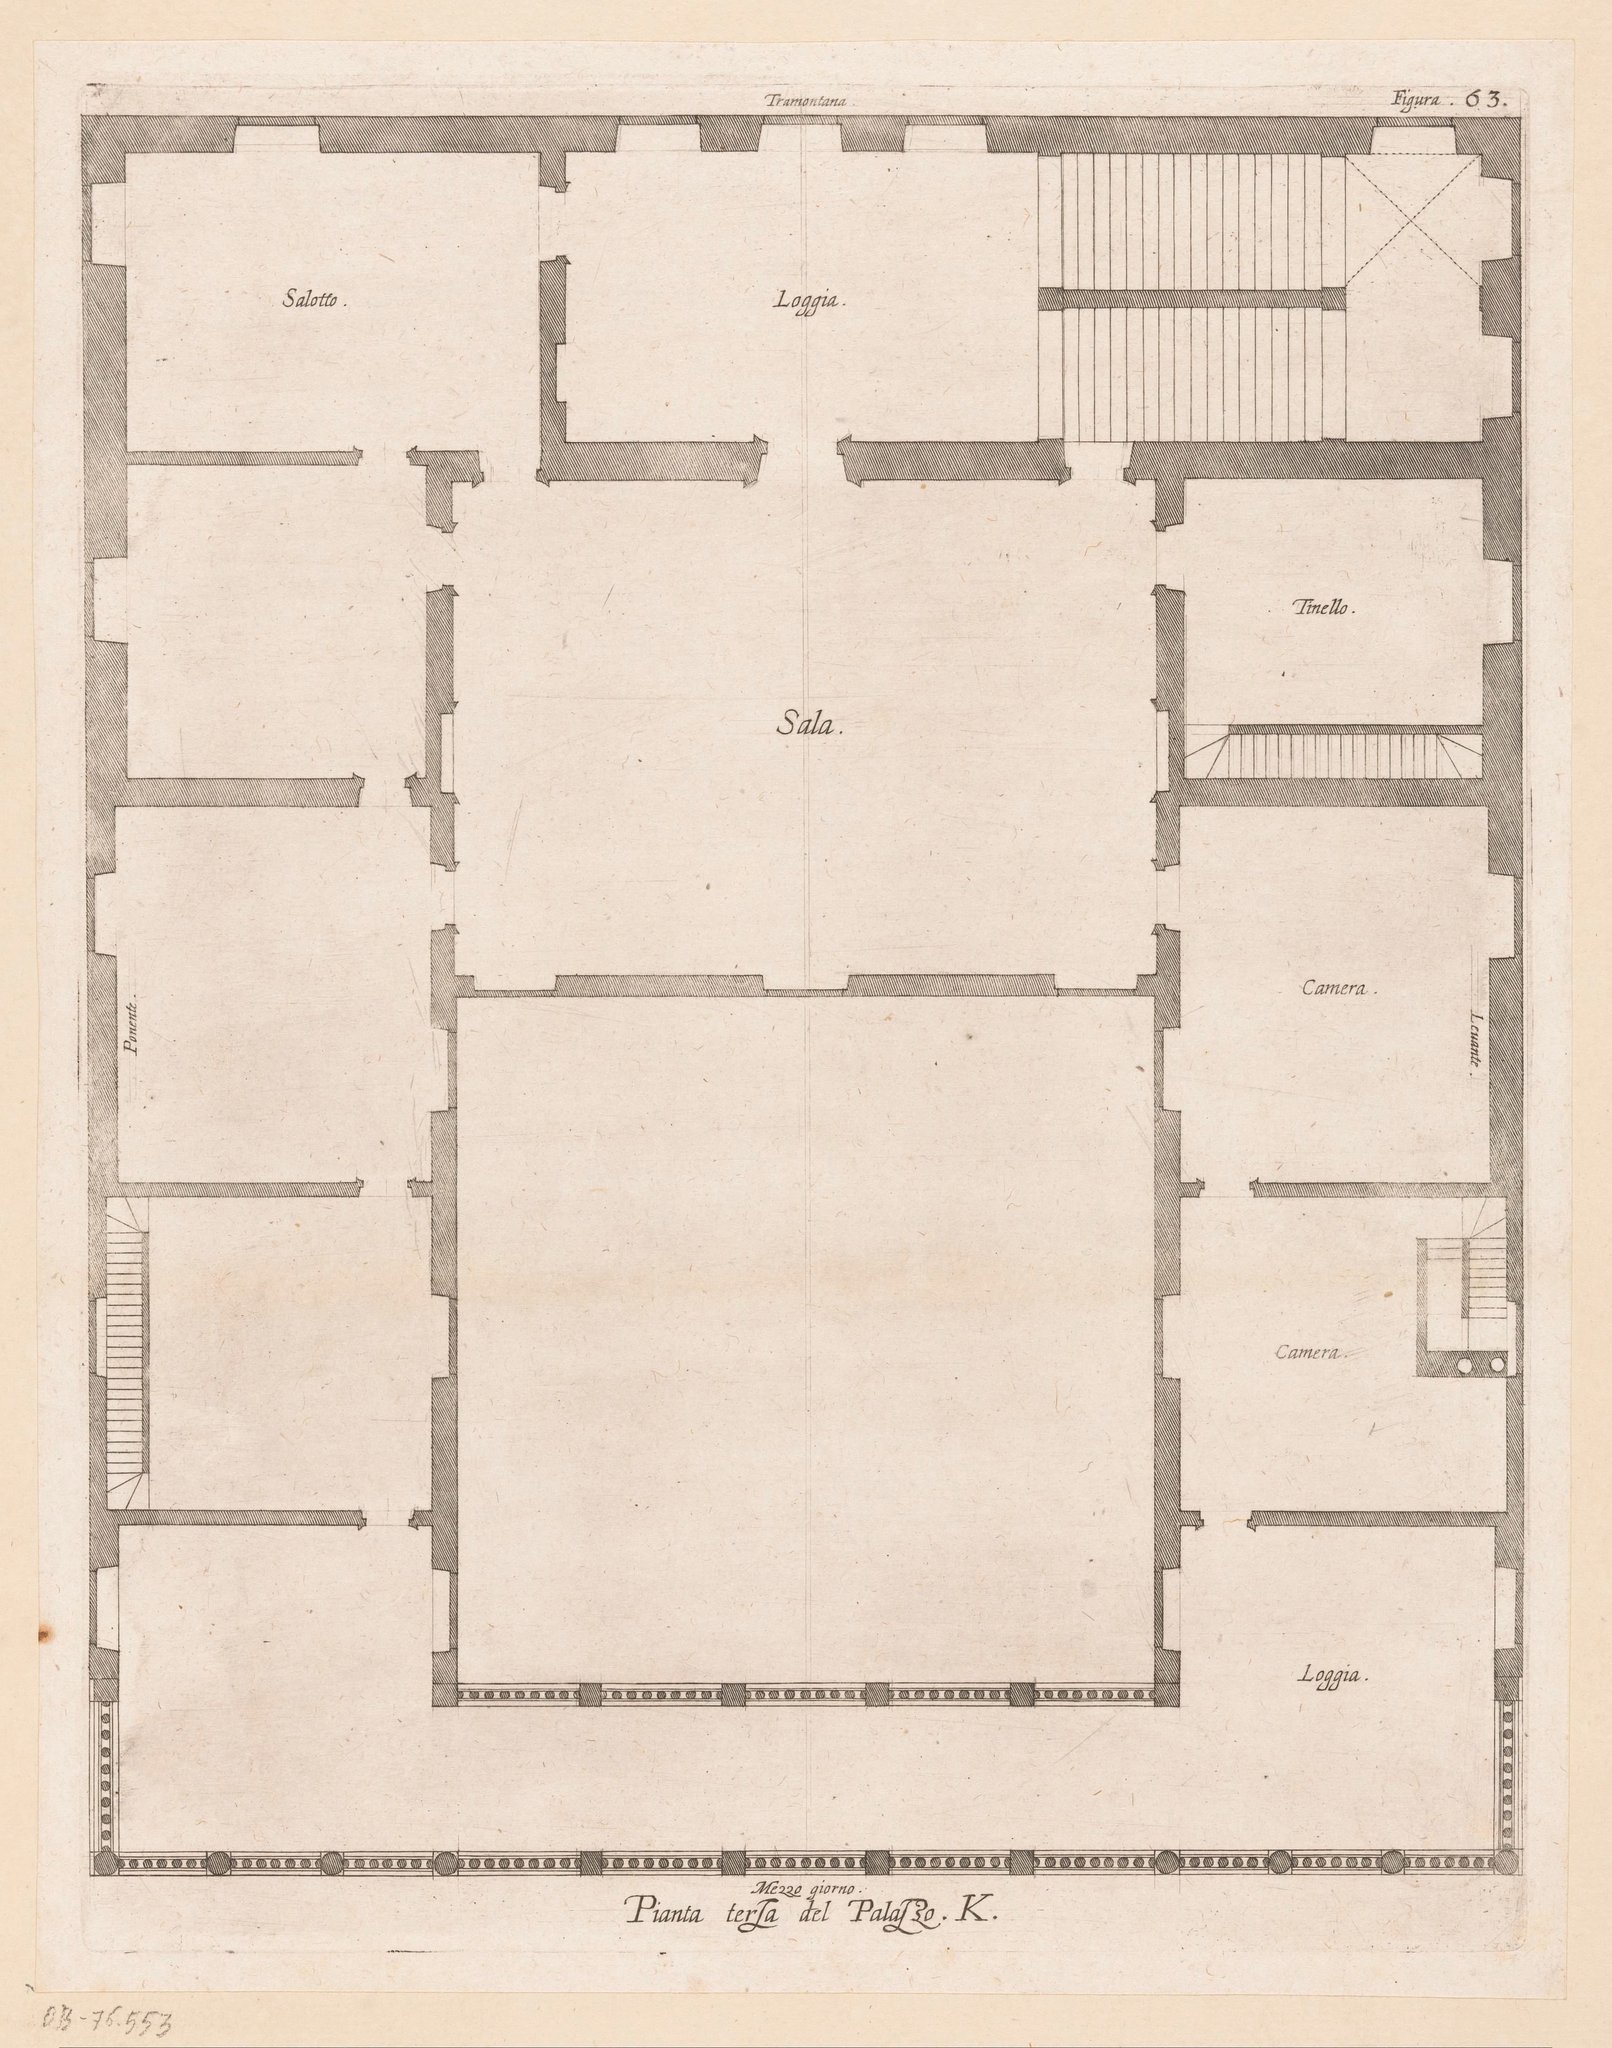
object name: ornament print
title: Pianta terza del Palazzo. K.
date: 1622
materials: paper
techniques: engraving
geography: antwerp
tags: hôtel, i.e. small palace in city - aa - civic architecture: inside, plan ~ architecture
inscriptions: collector's mark: Lugt 240